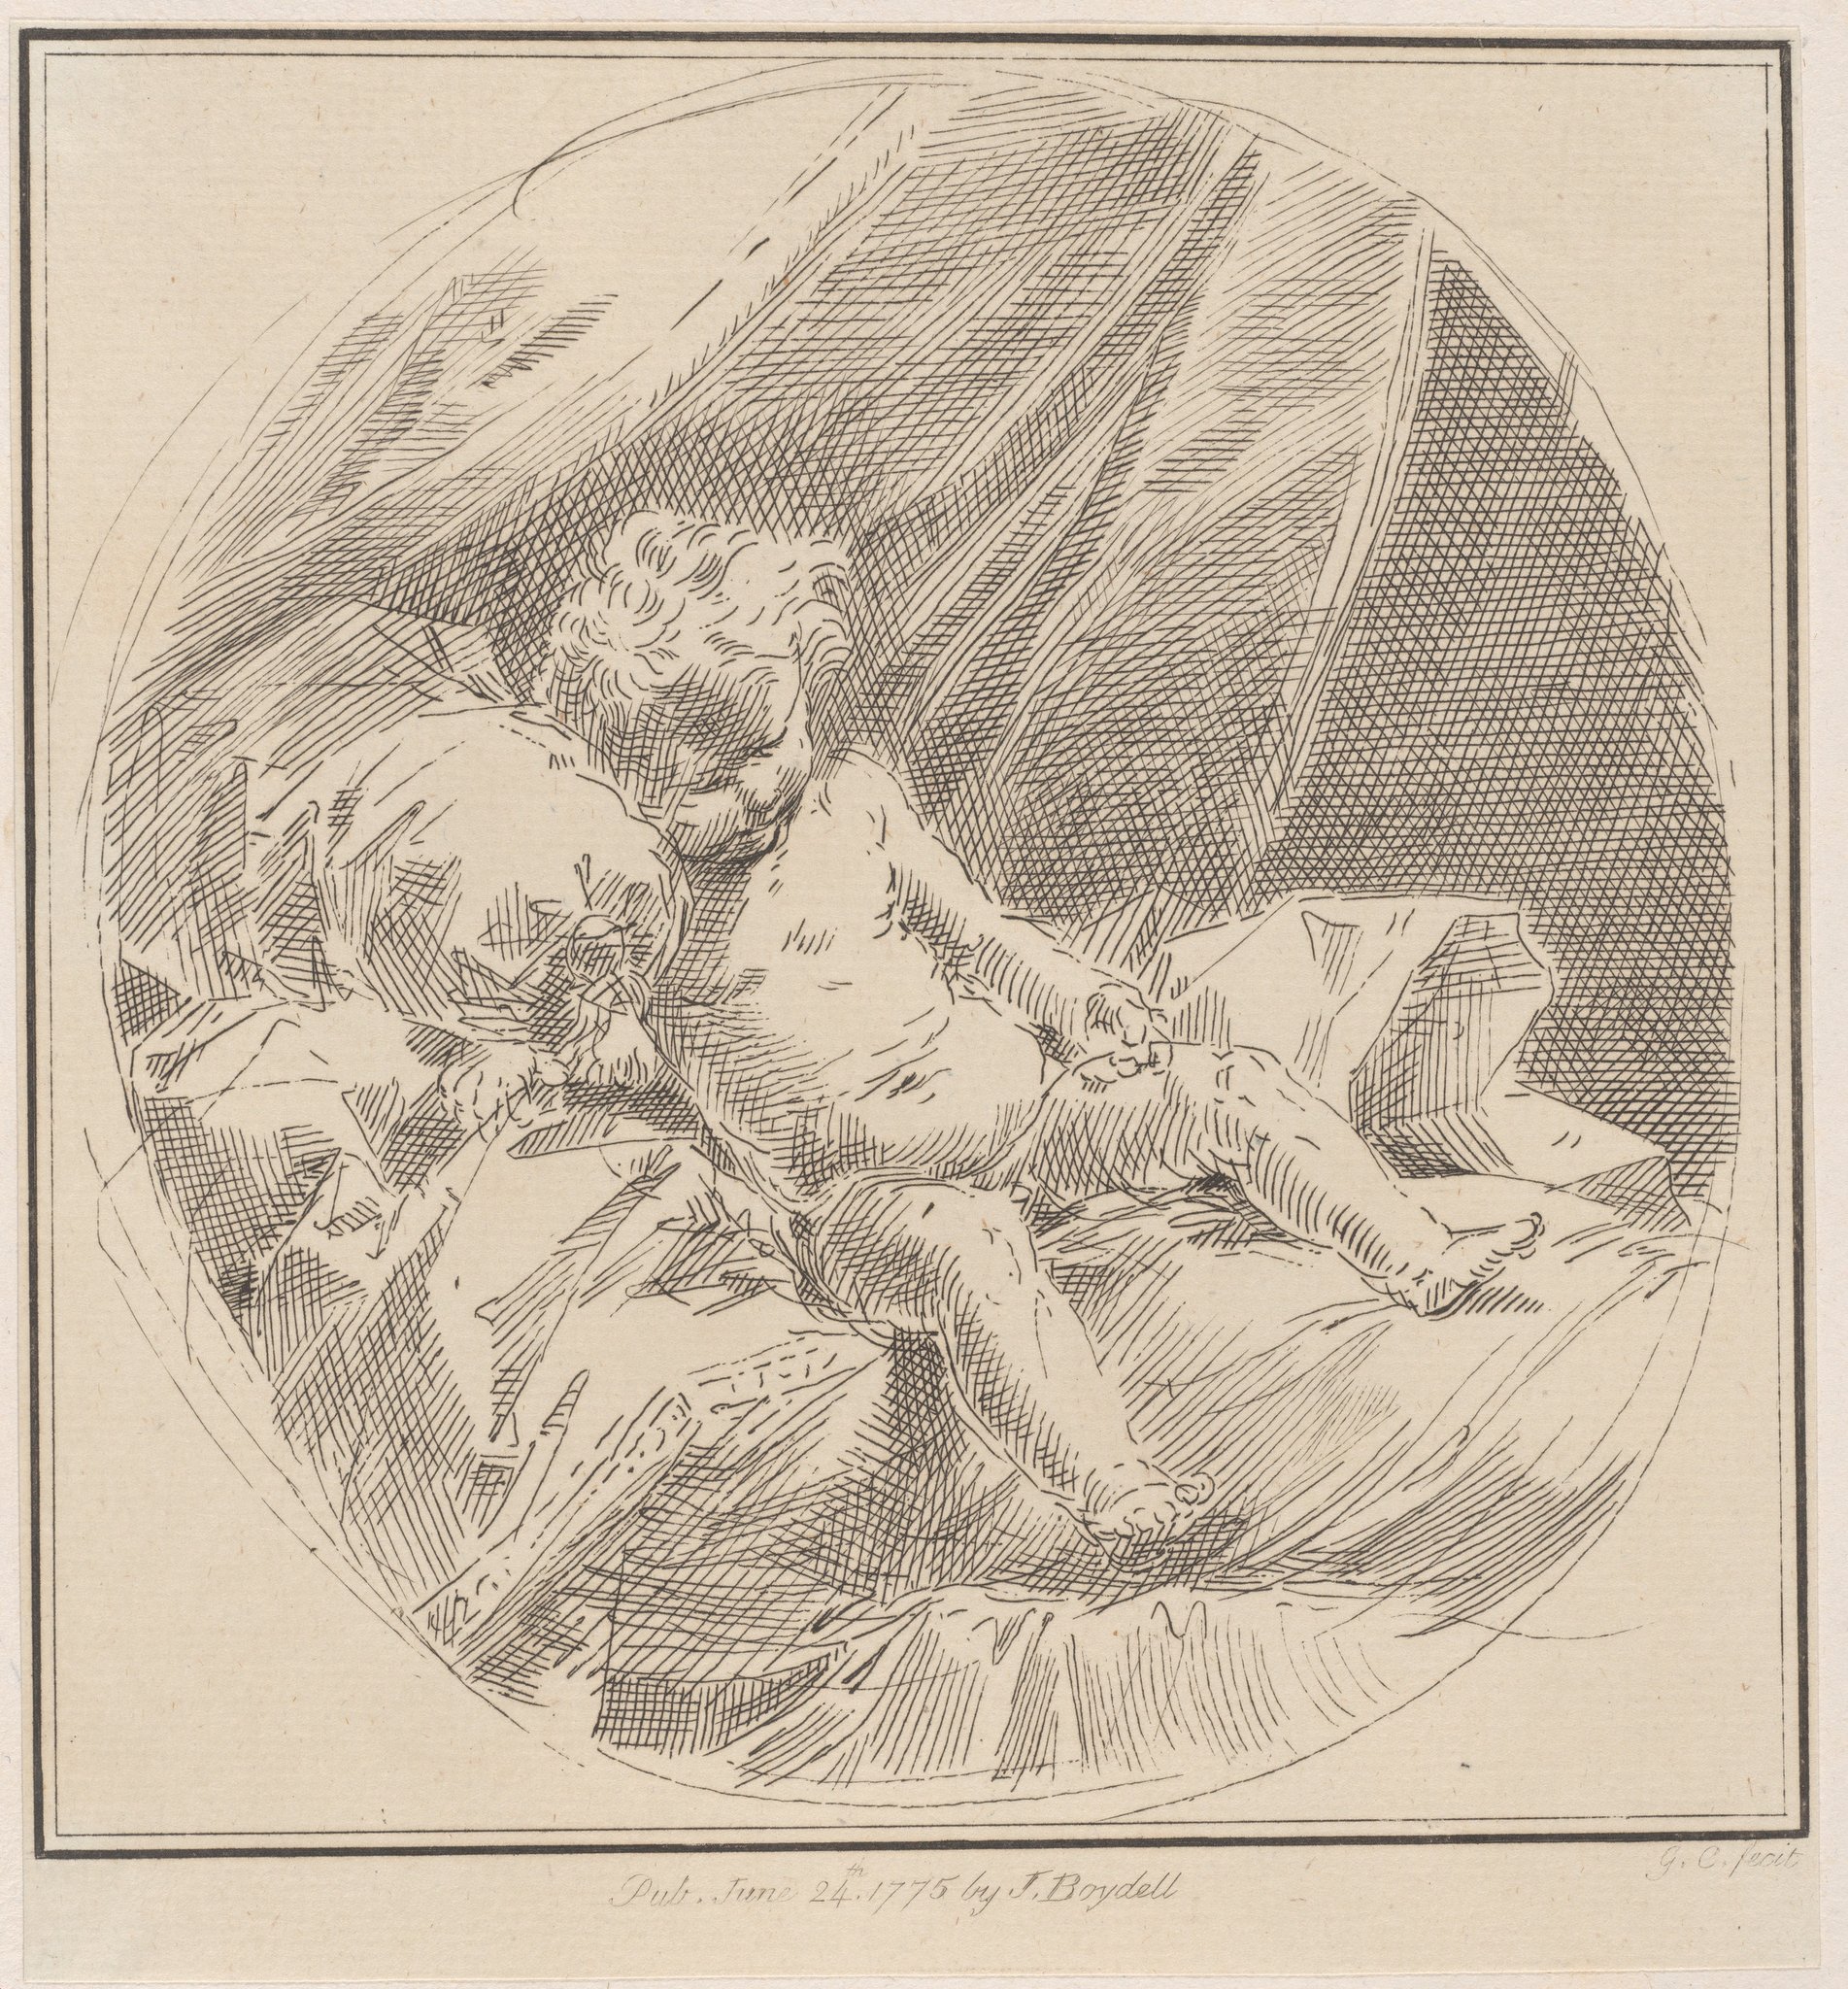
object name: print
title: Putto reclining on a bed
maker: giuseppe canale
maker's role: artist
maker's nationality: italian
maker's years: 1725-1802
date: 1775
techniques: etching